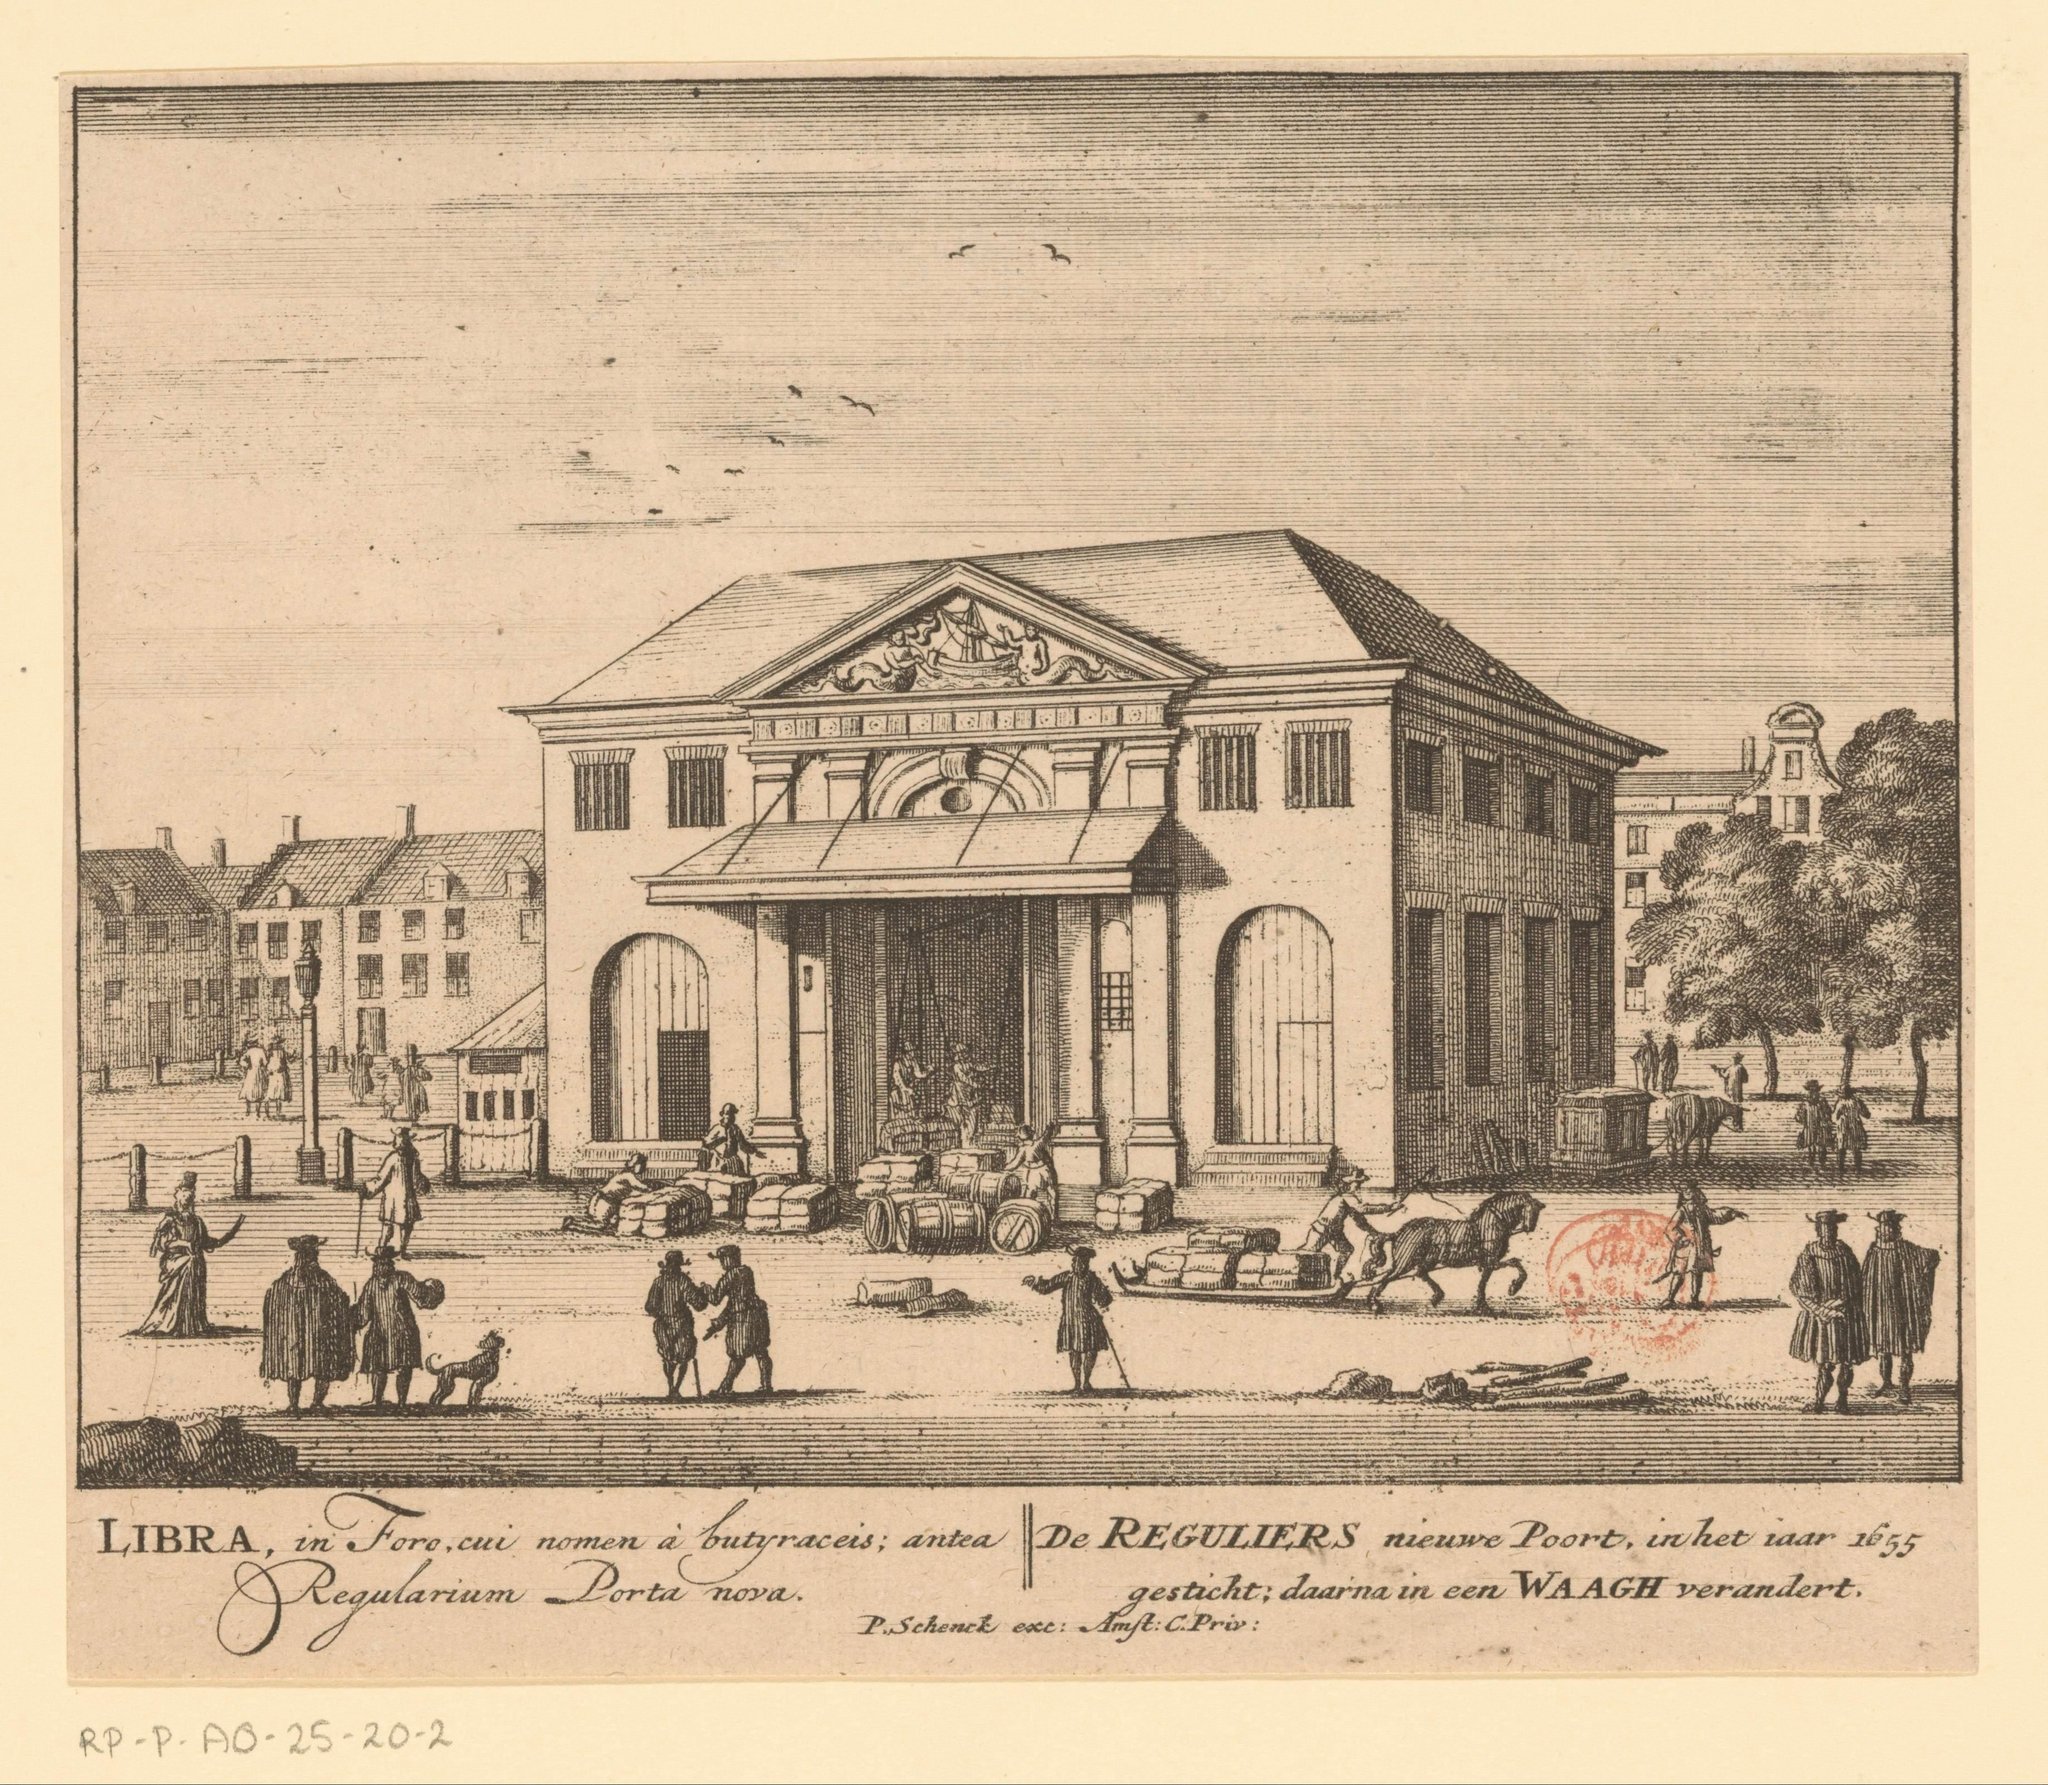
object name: print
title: 100 Afbeeldinge der voornaamste gebouwen van Amsterdam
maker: Anonymous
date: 1710-1711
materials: paper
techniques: engraving, etching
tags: weigh-house, square, place, circus, etc. (+ city(-scape) with figures, staffage)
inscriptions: collector's mark: Lugt 195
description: Genummerde staat van prent ook gebruikt in: 100 Afbeeldinge der voornaamste gebouwen van Amsterdam. Amsterdam, Pieter Schenk (I), s.a. [1710-1711]. En in: 100 Afbeeldinge der voornaamste gebouwen van Amsterdam. Amsterdam, Barent Greve, s.a. [1757-1766].* *In de tweede uitgave, uitgegeven door Barent Greve, is alleen de titelprent aangepast. De overige prenten zijn onveranderd gebleven.